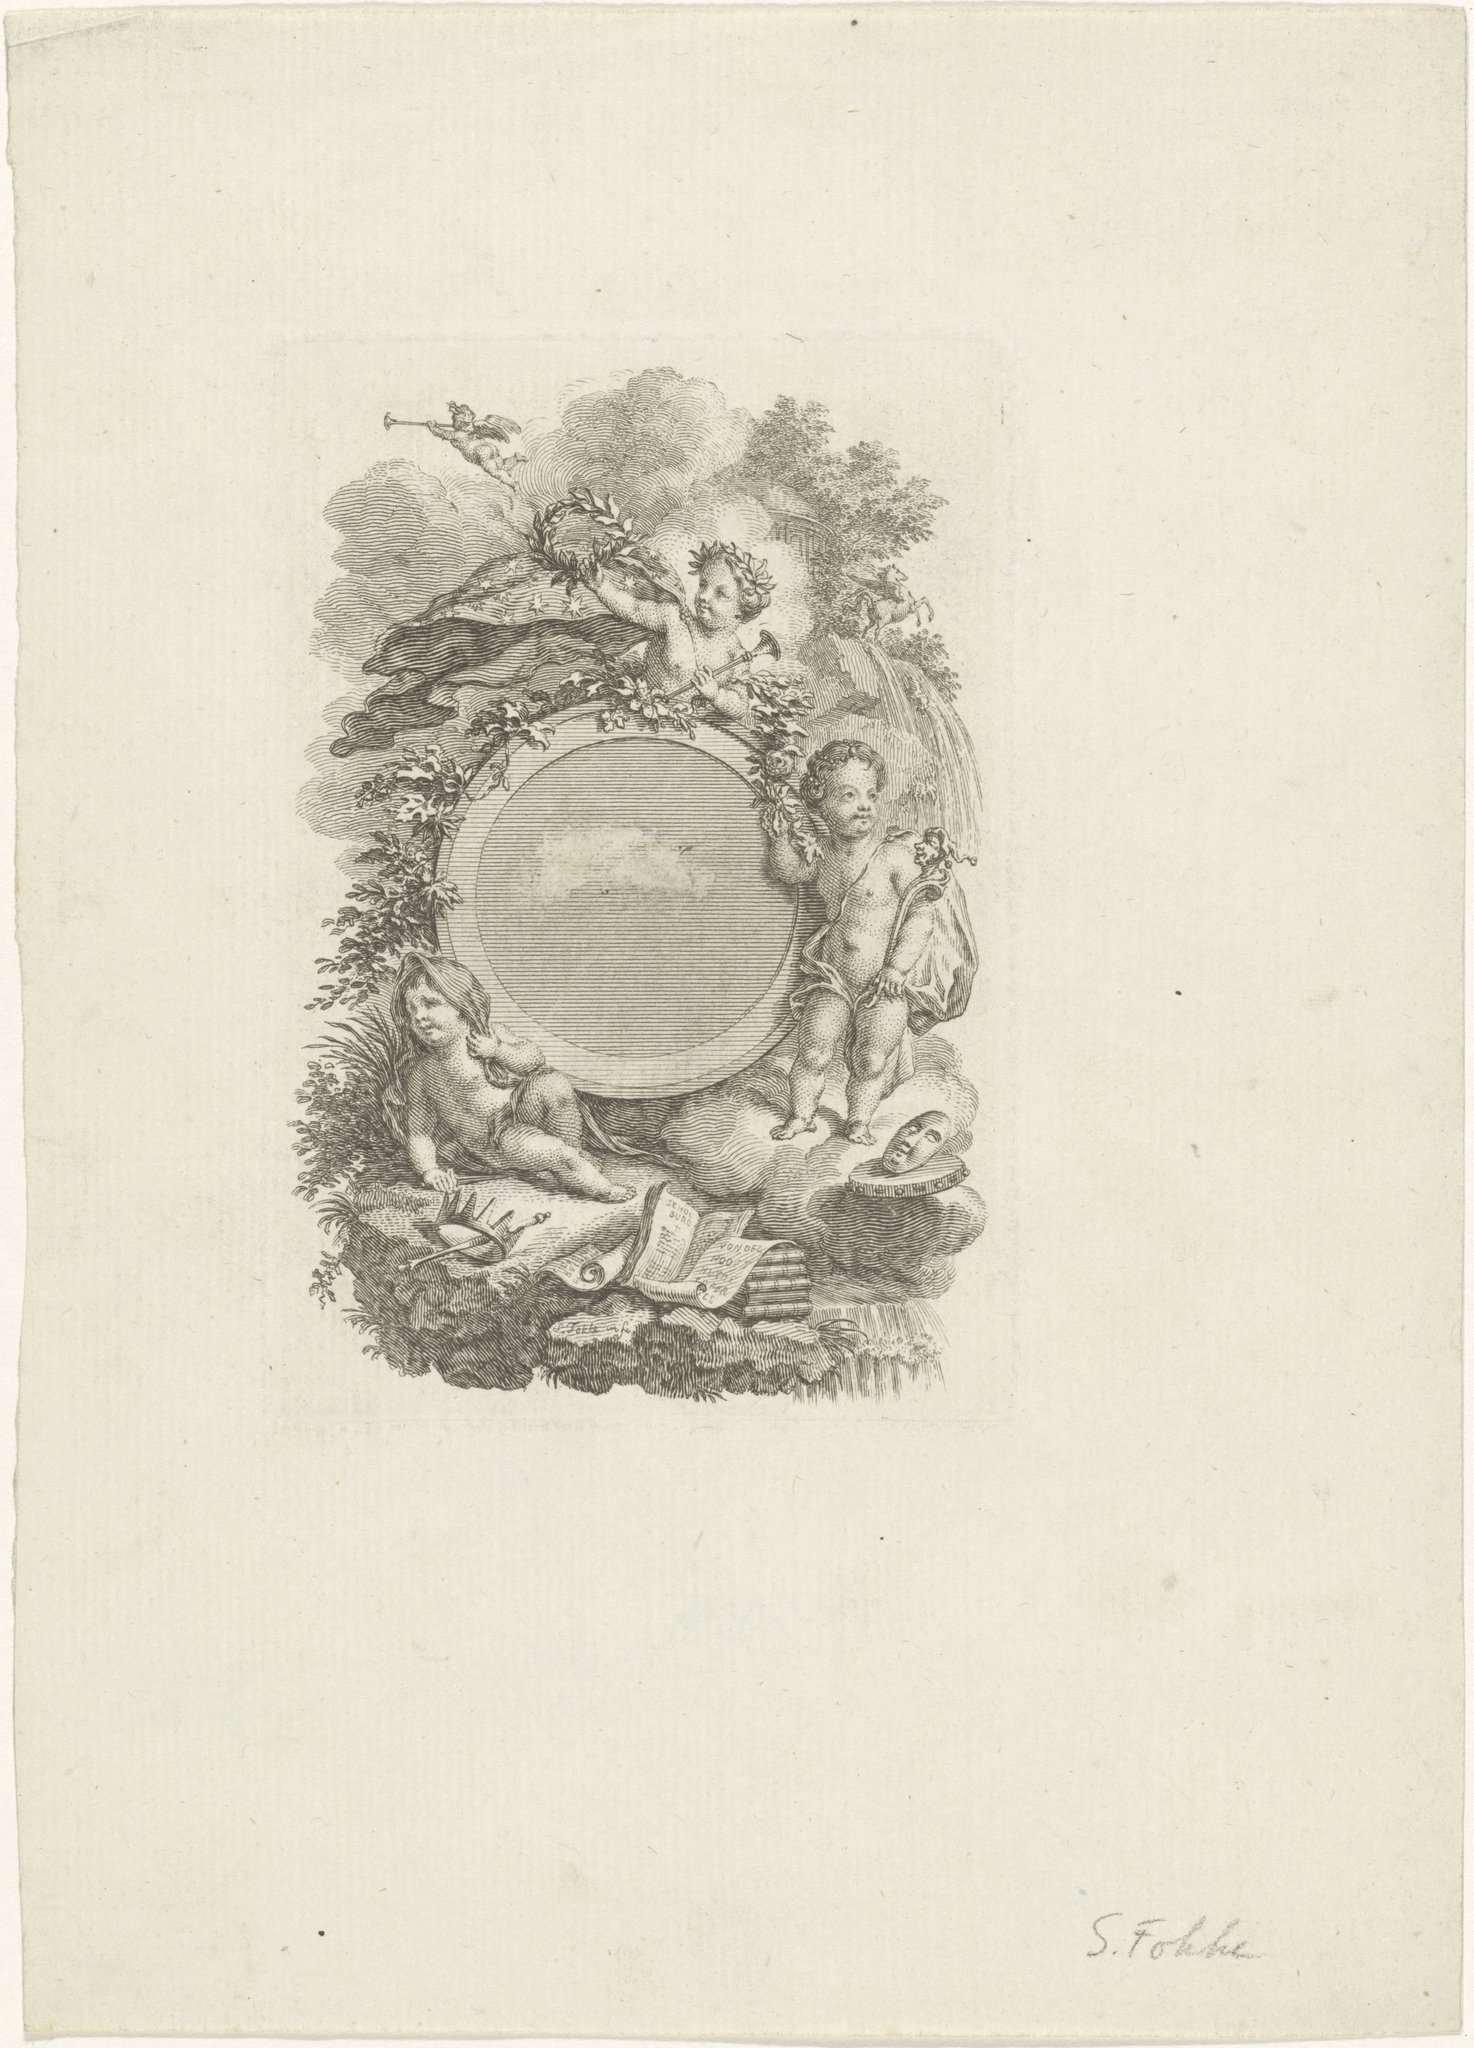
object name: print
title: Drie putti rond een medaillon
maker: simon fokke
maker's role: draughtsman, print maker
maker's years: 1712-1784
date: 1722-1784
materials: paper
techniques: etching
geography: amsterdam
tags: crowning with laurel, single muses, cupids: 'amores', 'amoretti', 'putti', jolly joker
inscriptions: collector's mark: Lugt 2228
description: Drie putti rond een leeg medaillon. Bovenaan wordt de medaillon gelauwerd door een putto met bazuin. De putto rechts houdt een narrenstok vast. Op de voorgrond liggen naast bladen met namen van toneelschrijvers een tamboerijn, masker en kroon met scepter, attributen van muzen.